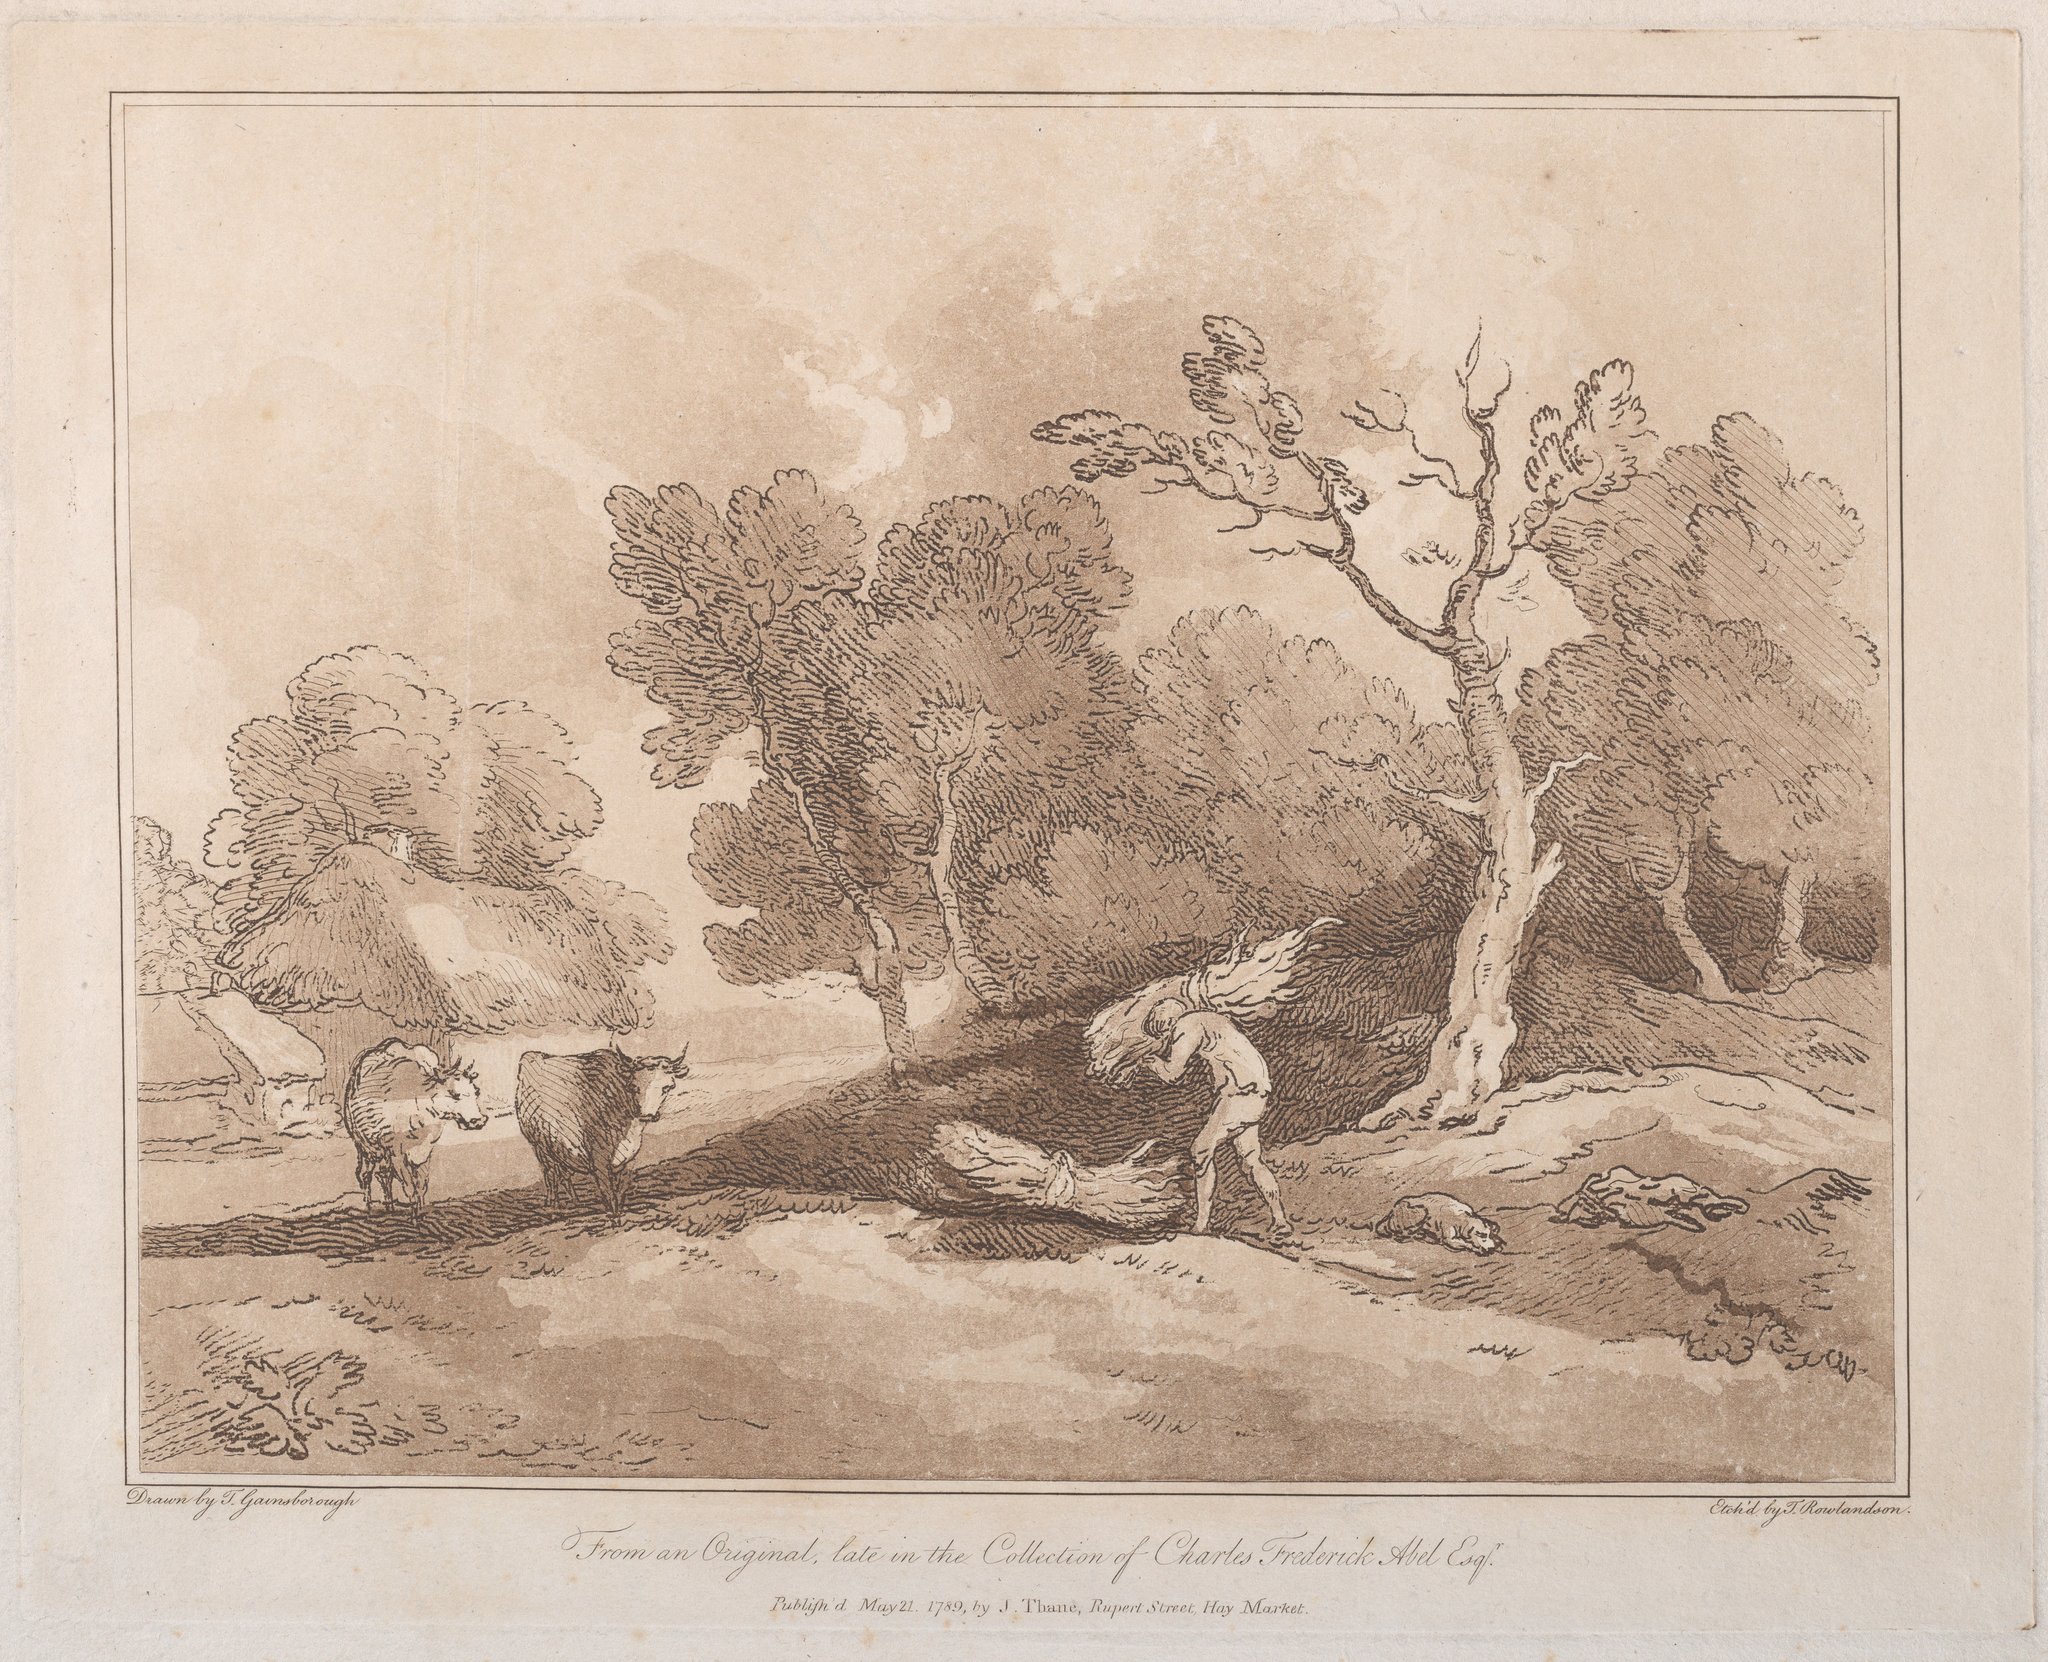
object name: print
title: Landscape with a Figure Carrying a Bundle of Branches, a Copice Behind, Two Cows in a Field at Left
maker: thomas rowlandson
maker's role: artist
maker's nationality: british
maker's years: 1757-1827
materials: ink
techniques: aquatint, etching, printing